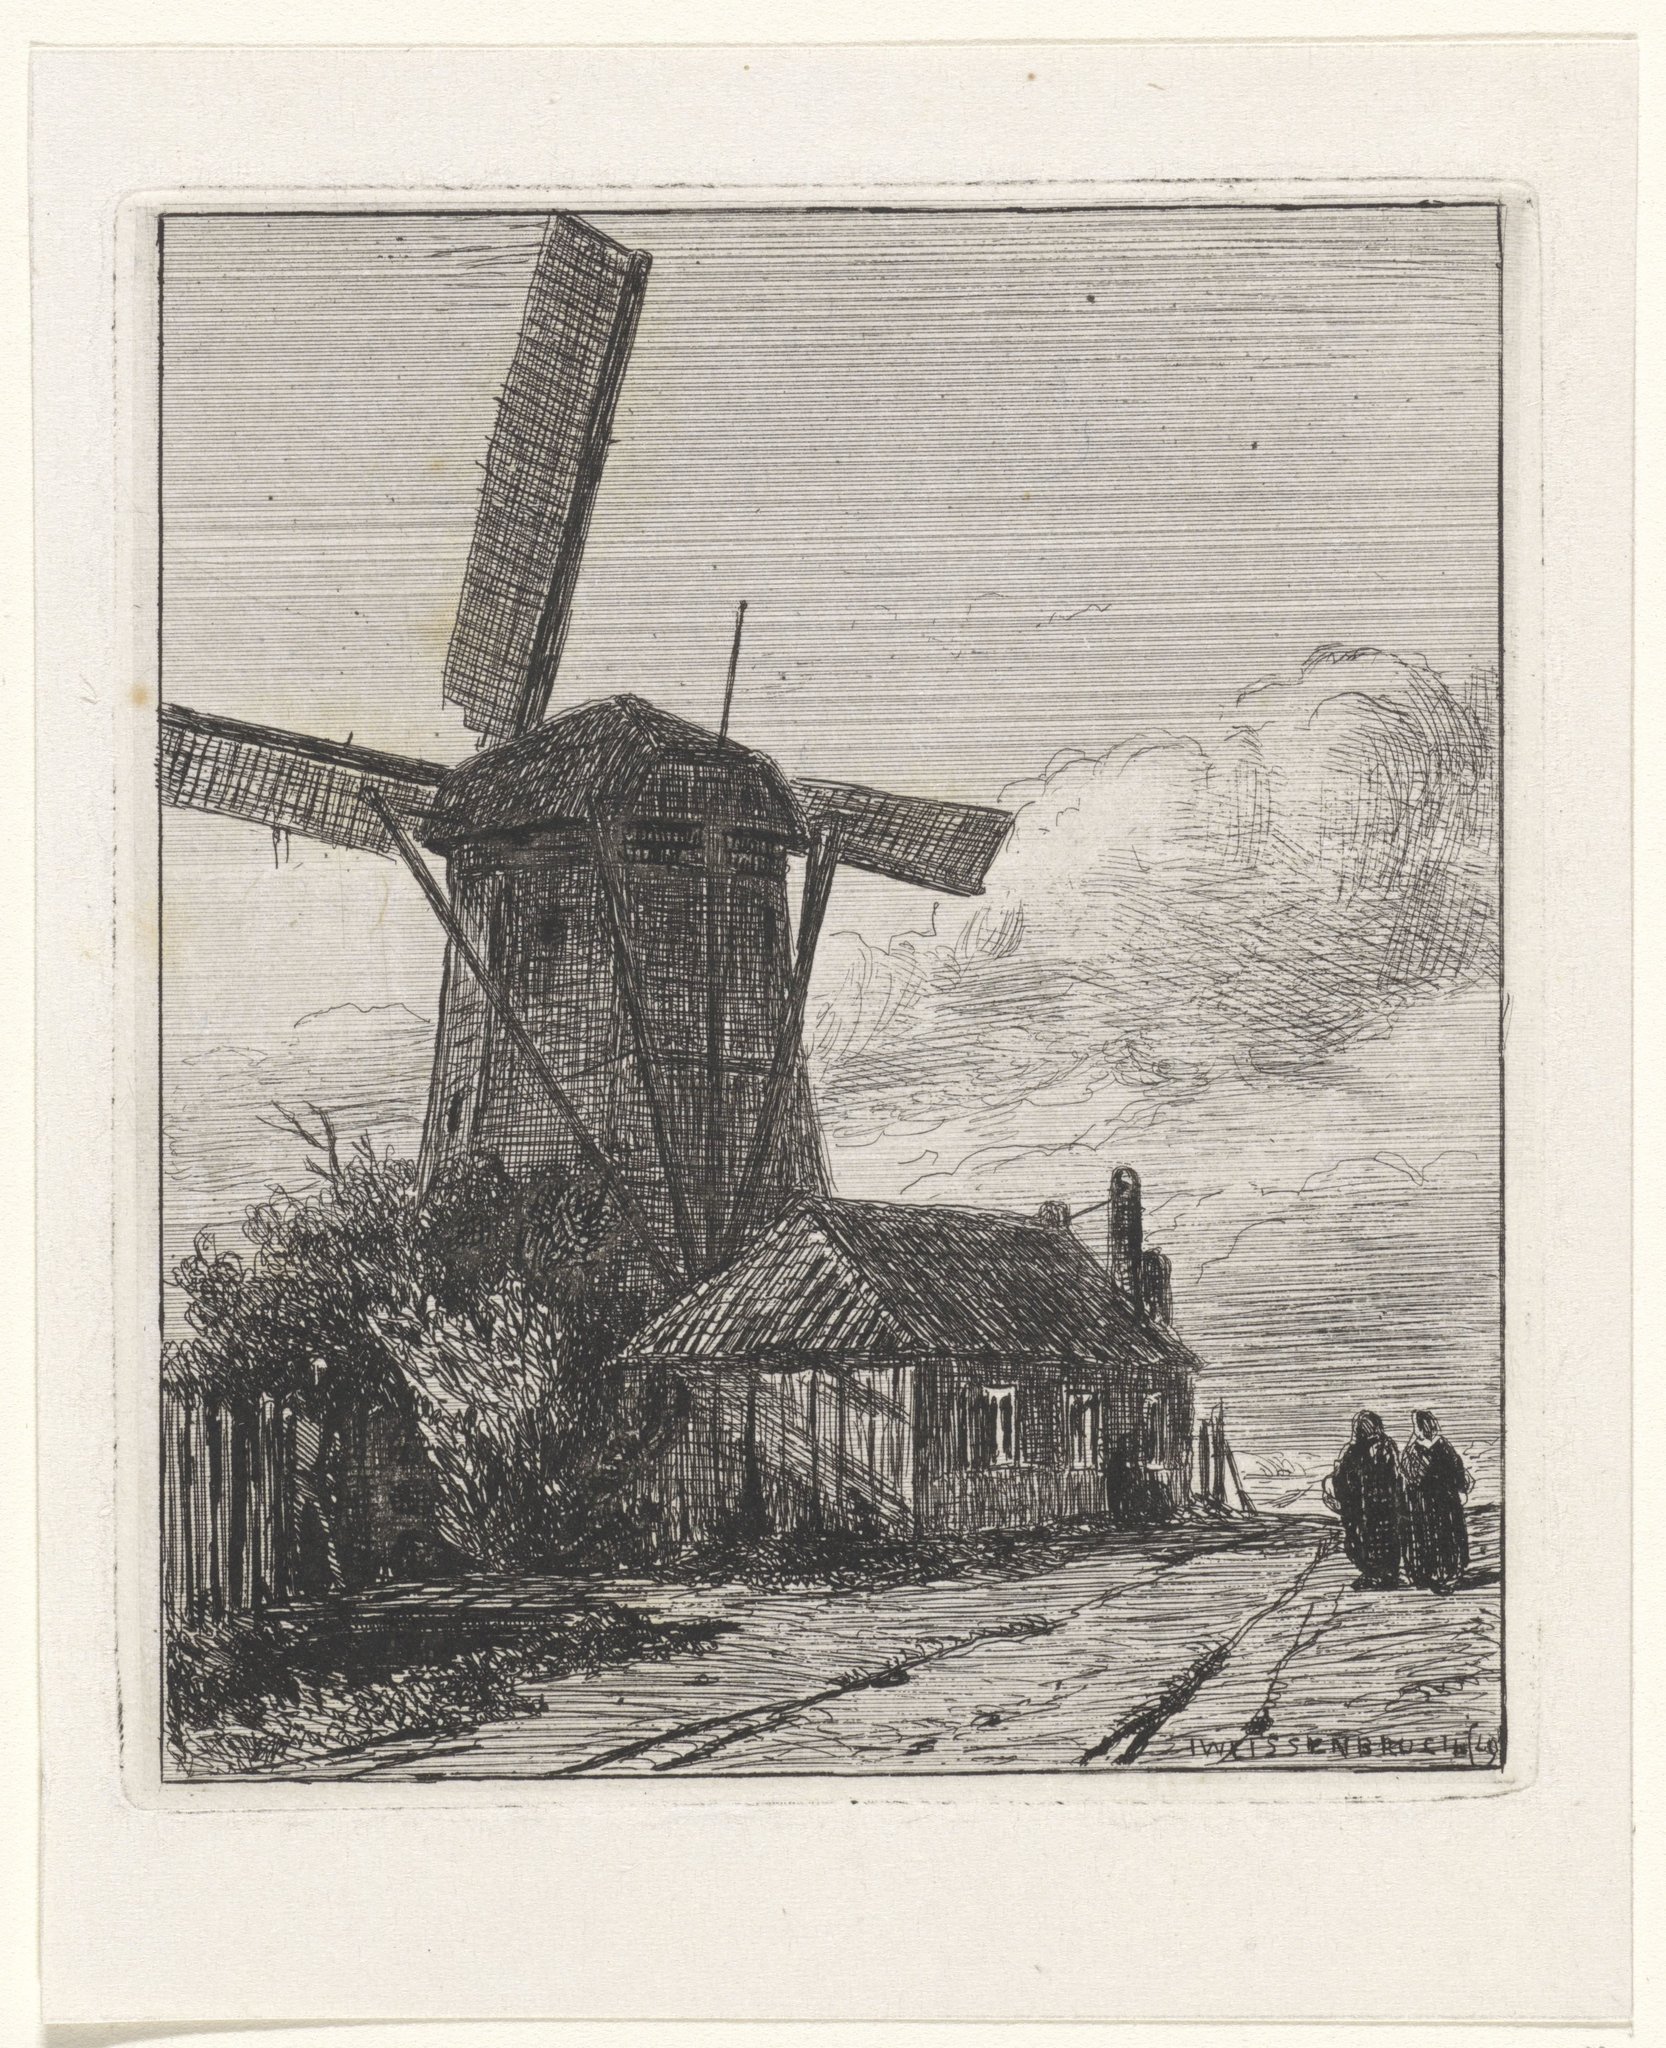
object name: print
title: Gezicht op de Trekweg te Den Haag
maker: jan weissenbruch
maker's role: painter, print maker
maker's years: 1822-1880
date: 1849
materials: paper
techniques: etching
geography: the hague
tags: fence, wall, paling, rural housing, e.g. country-house, villa, cottage, road, path, windmill in landscape, walking, windmill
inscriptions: collector's mark: Lugt 2228, collector's mark: Lugt 2760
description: Over de Trekweg lopen enkele figuren. Links is een molen achter een huis weergegeven.